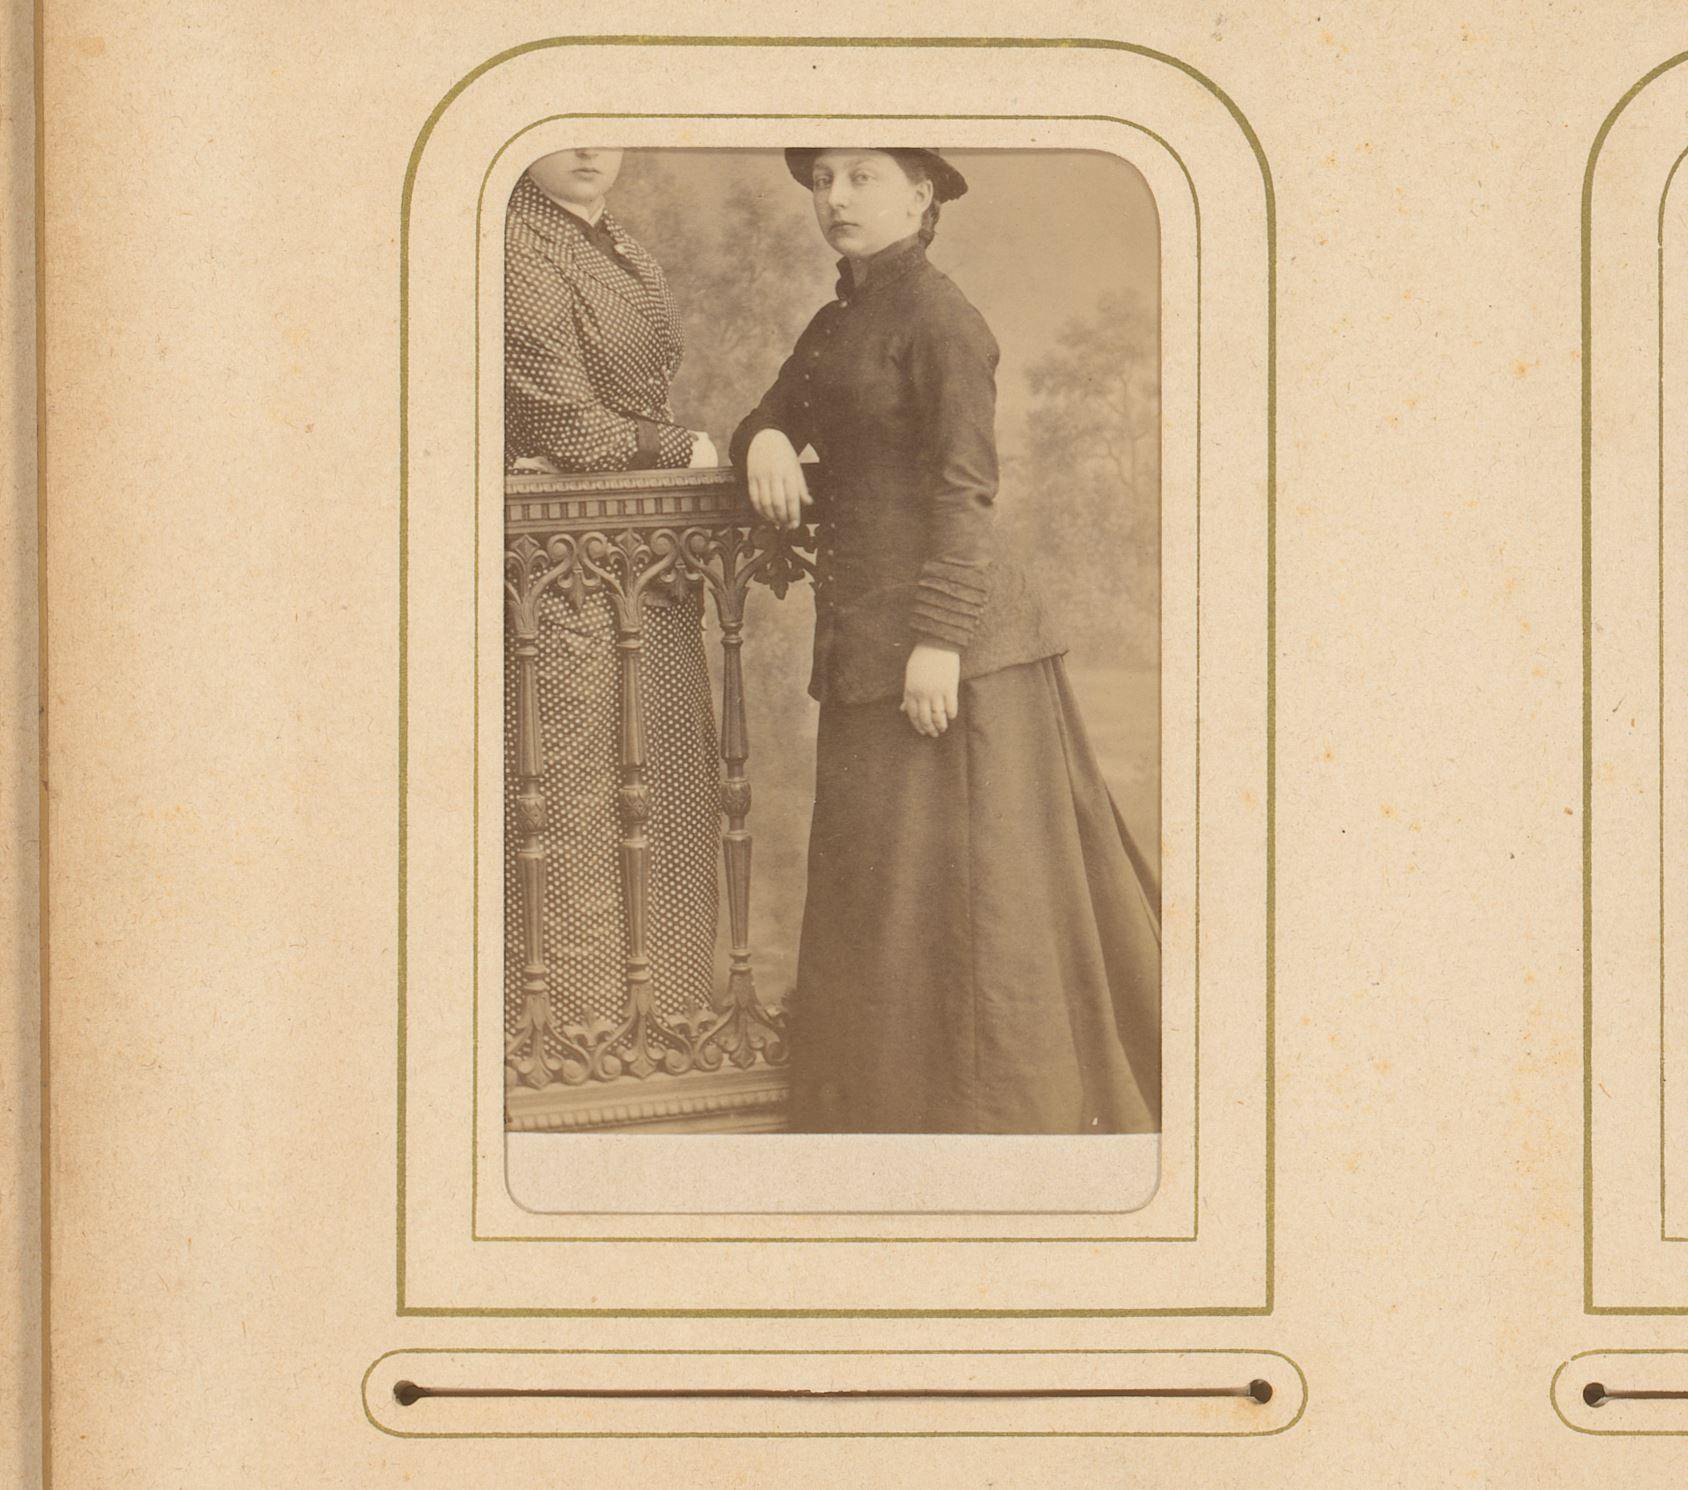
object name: album leaf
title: Portret van twee jonge vrouwen, staand bij een hek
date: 1865-1903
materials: cardboard, photographic support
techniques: albumen print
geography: the hague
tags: historical persons - bb - woman, standing figure - aa - female human figure (+ two persons), fence, wall, paling, adolescent, young woman, maiden (+ two persons)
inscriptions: inscription: ‘De Lavieter & Co./ PHOTOGRAPHES DE S. M. DE ROI/ ET DE SON ALTESSE ROYALE/ LE PRINCE ALEXANDRE/ DES PAYS-BAS./ LA HAYE.’